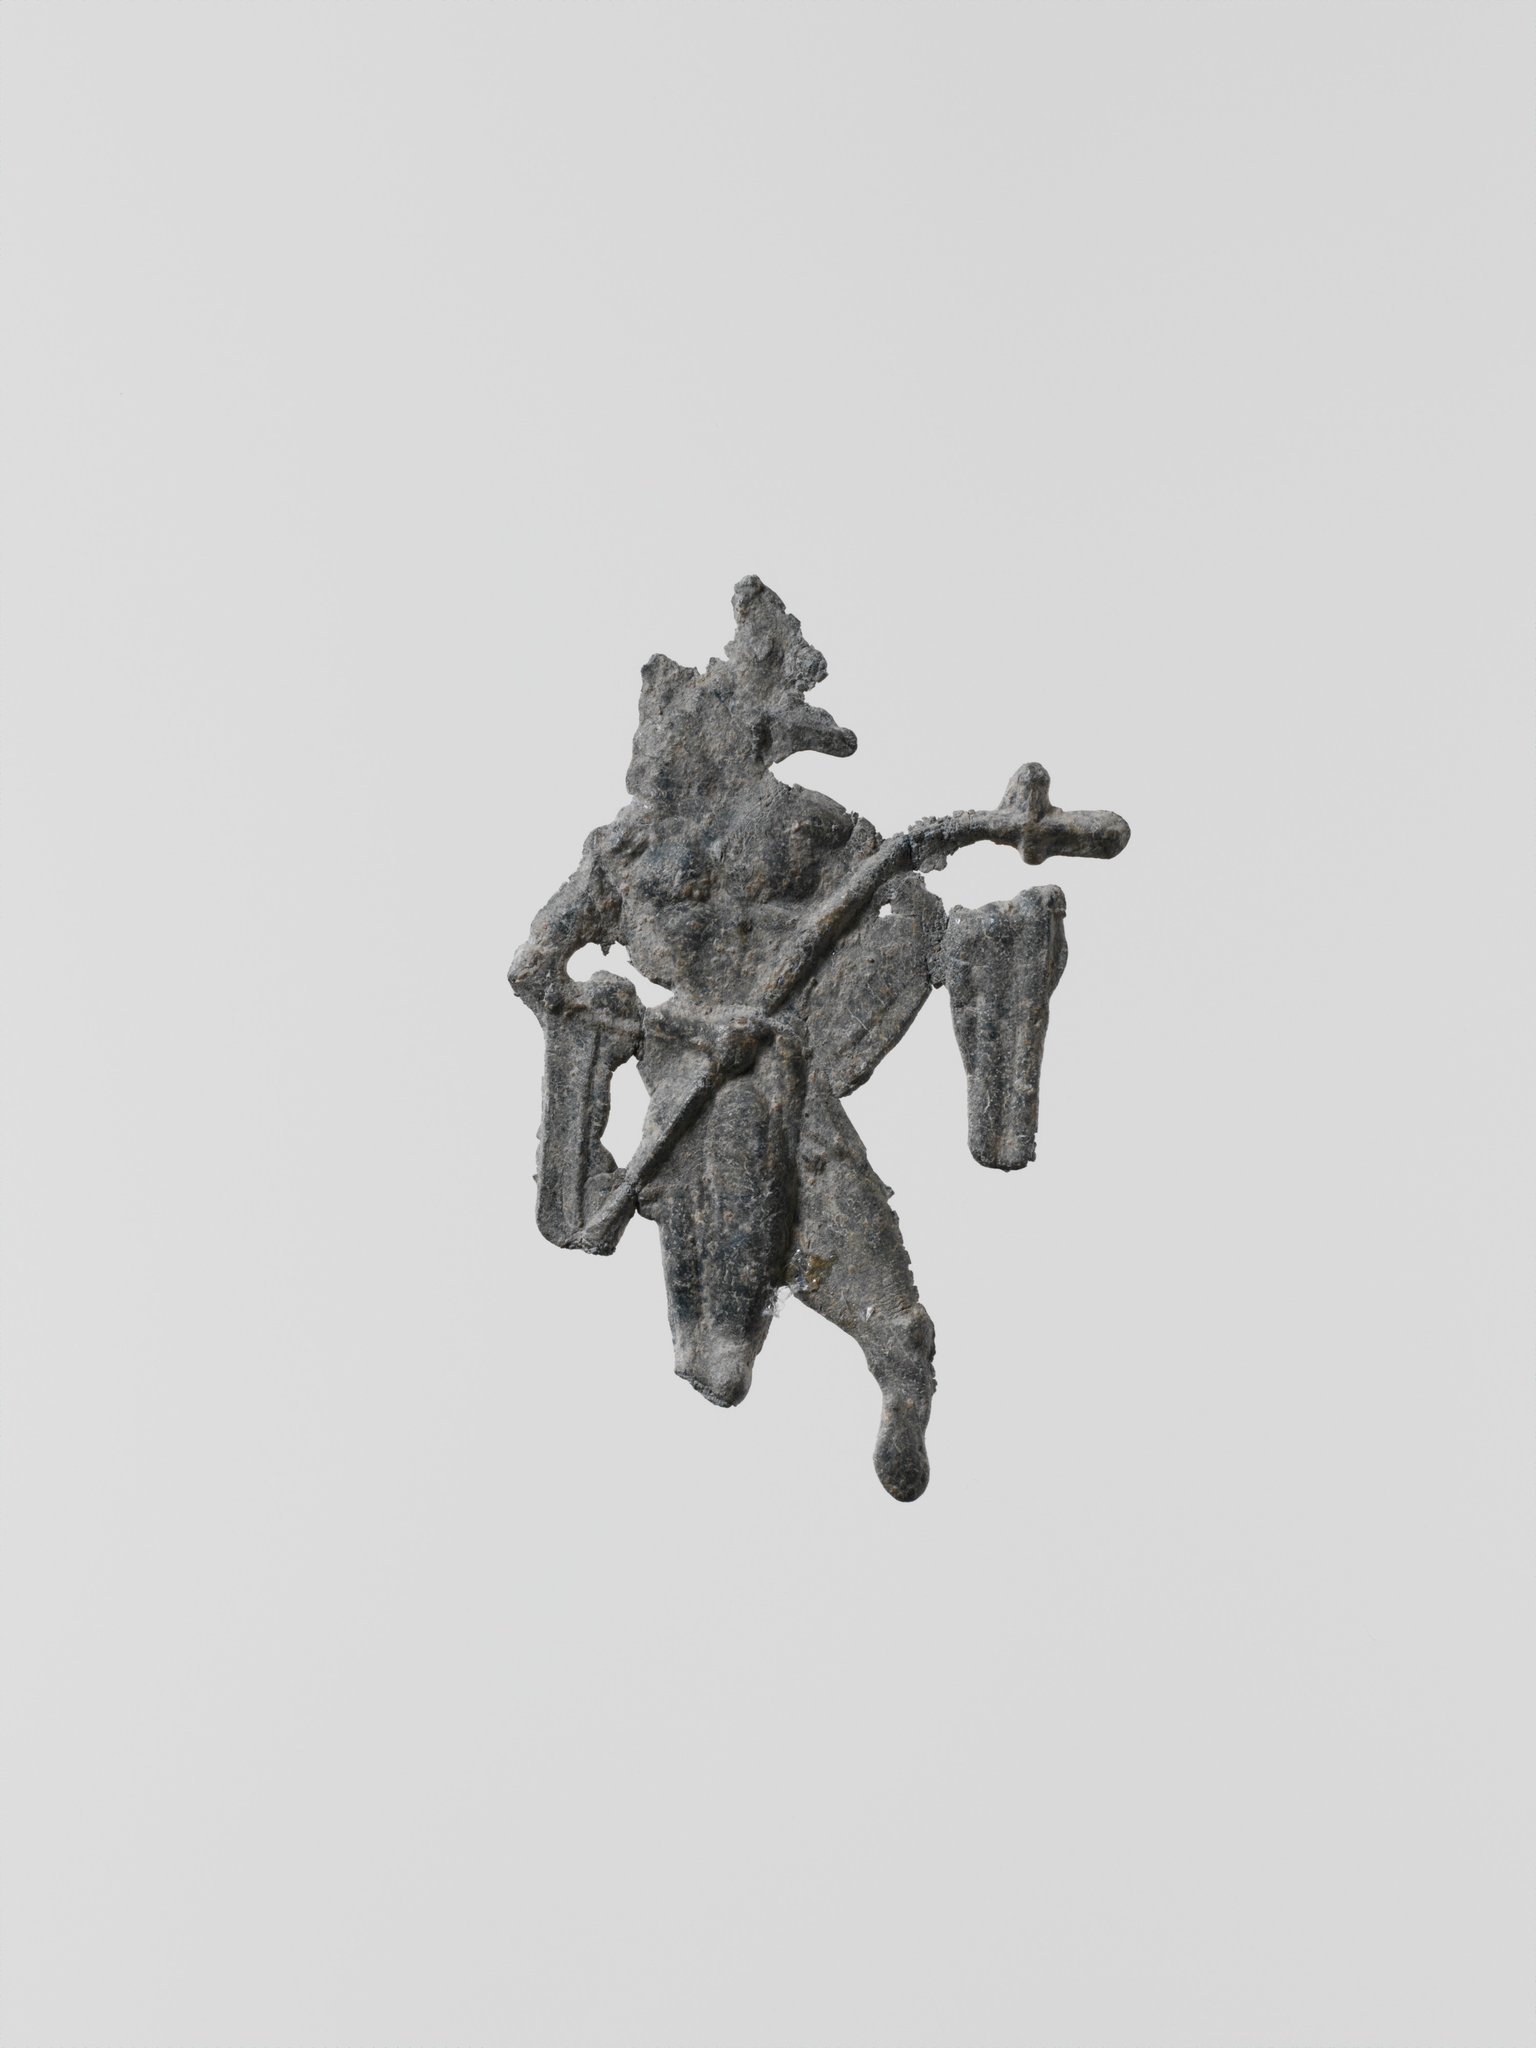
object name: statuette of poseidon, 4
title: Lead figure of a man with a spear or scepter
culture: greek, laconian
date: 600-401 BCE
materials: lead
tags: spears,men